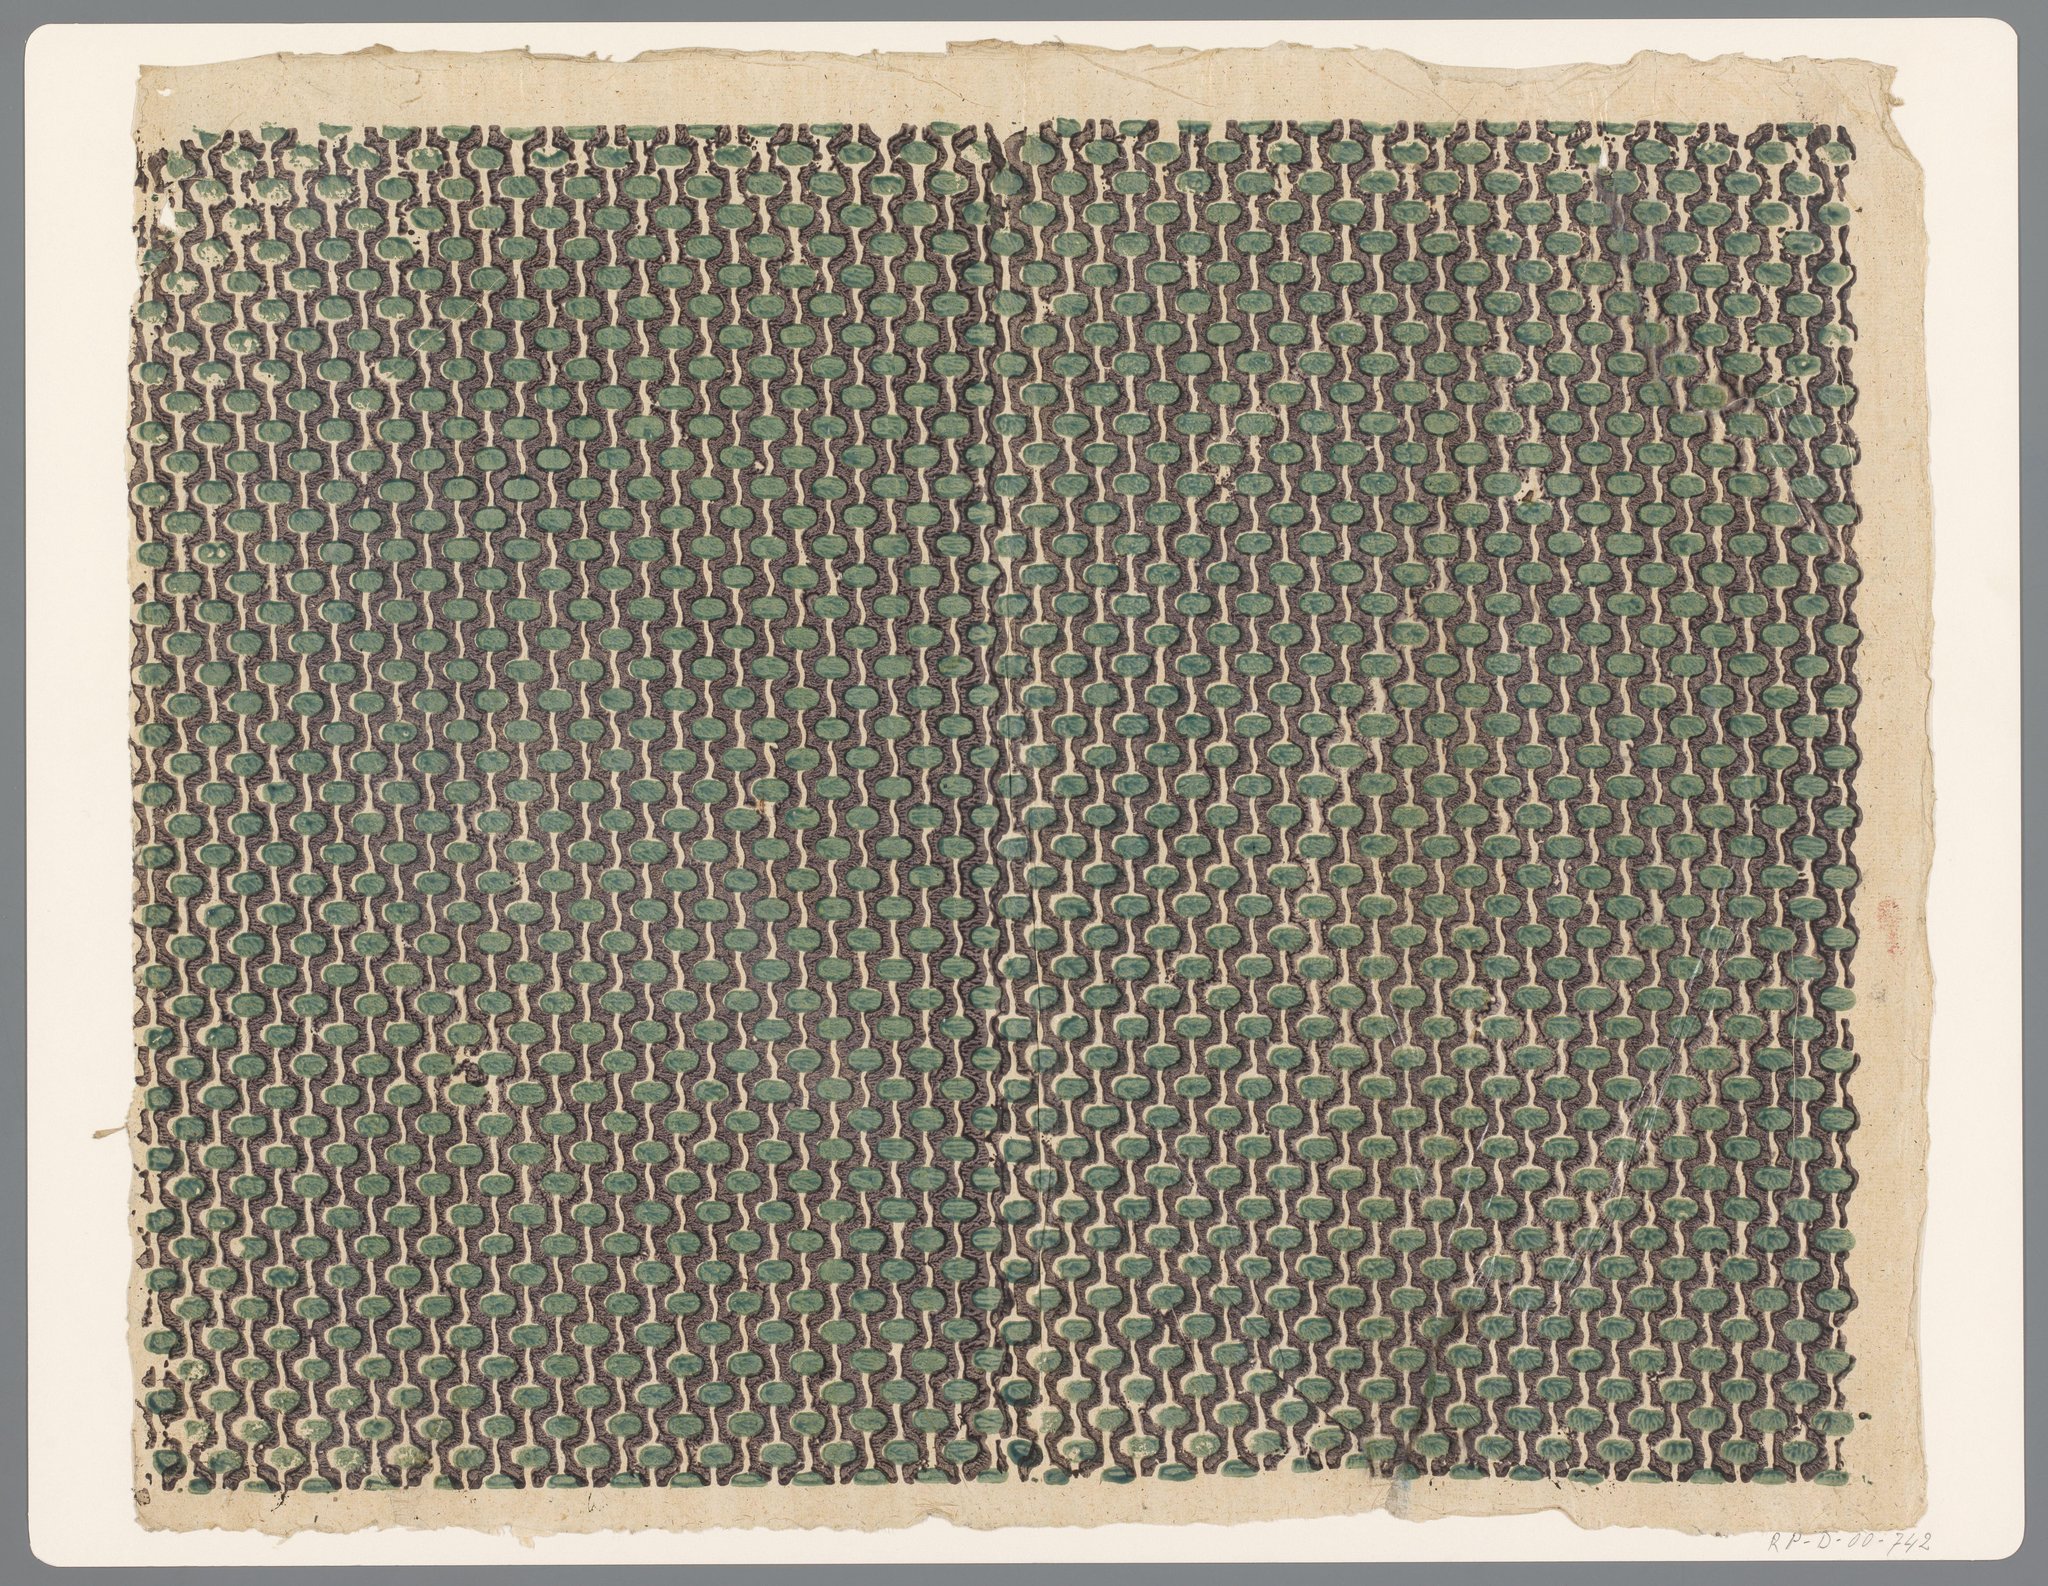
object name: printed paper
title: Blad met banenpatroon van ovaal motief verbonden door golvende lijn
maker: Anonymous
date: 1750-1900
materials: lacquer, paper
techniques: printing block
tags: fantasy ornament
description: Blad met een verticaal banenpatroon van ovaal motief verbonden door uitgespaarde golvende lijn.